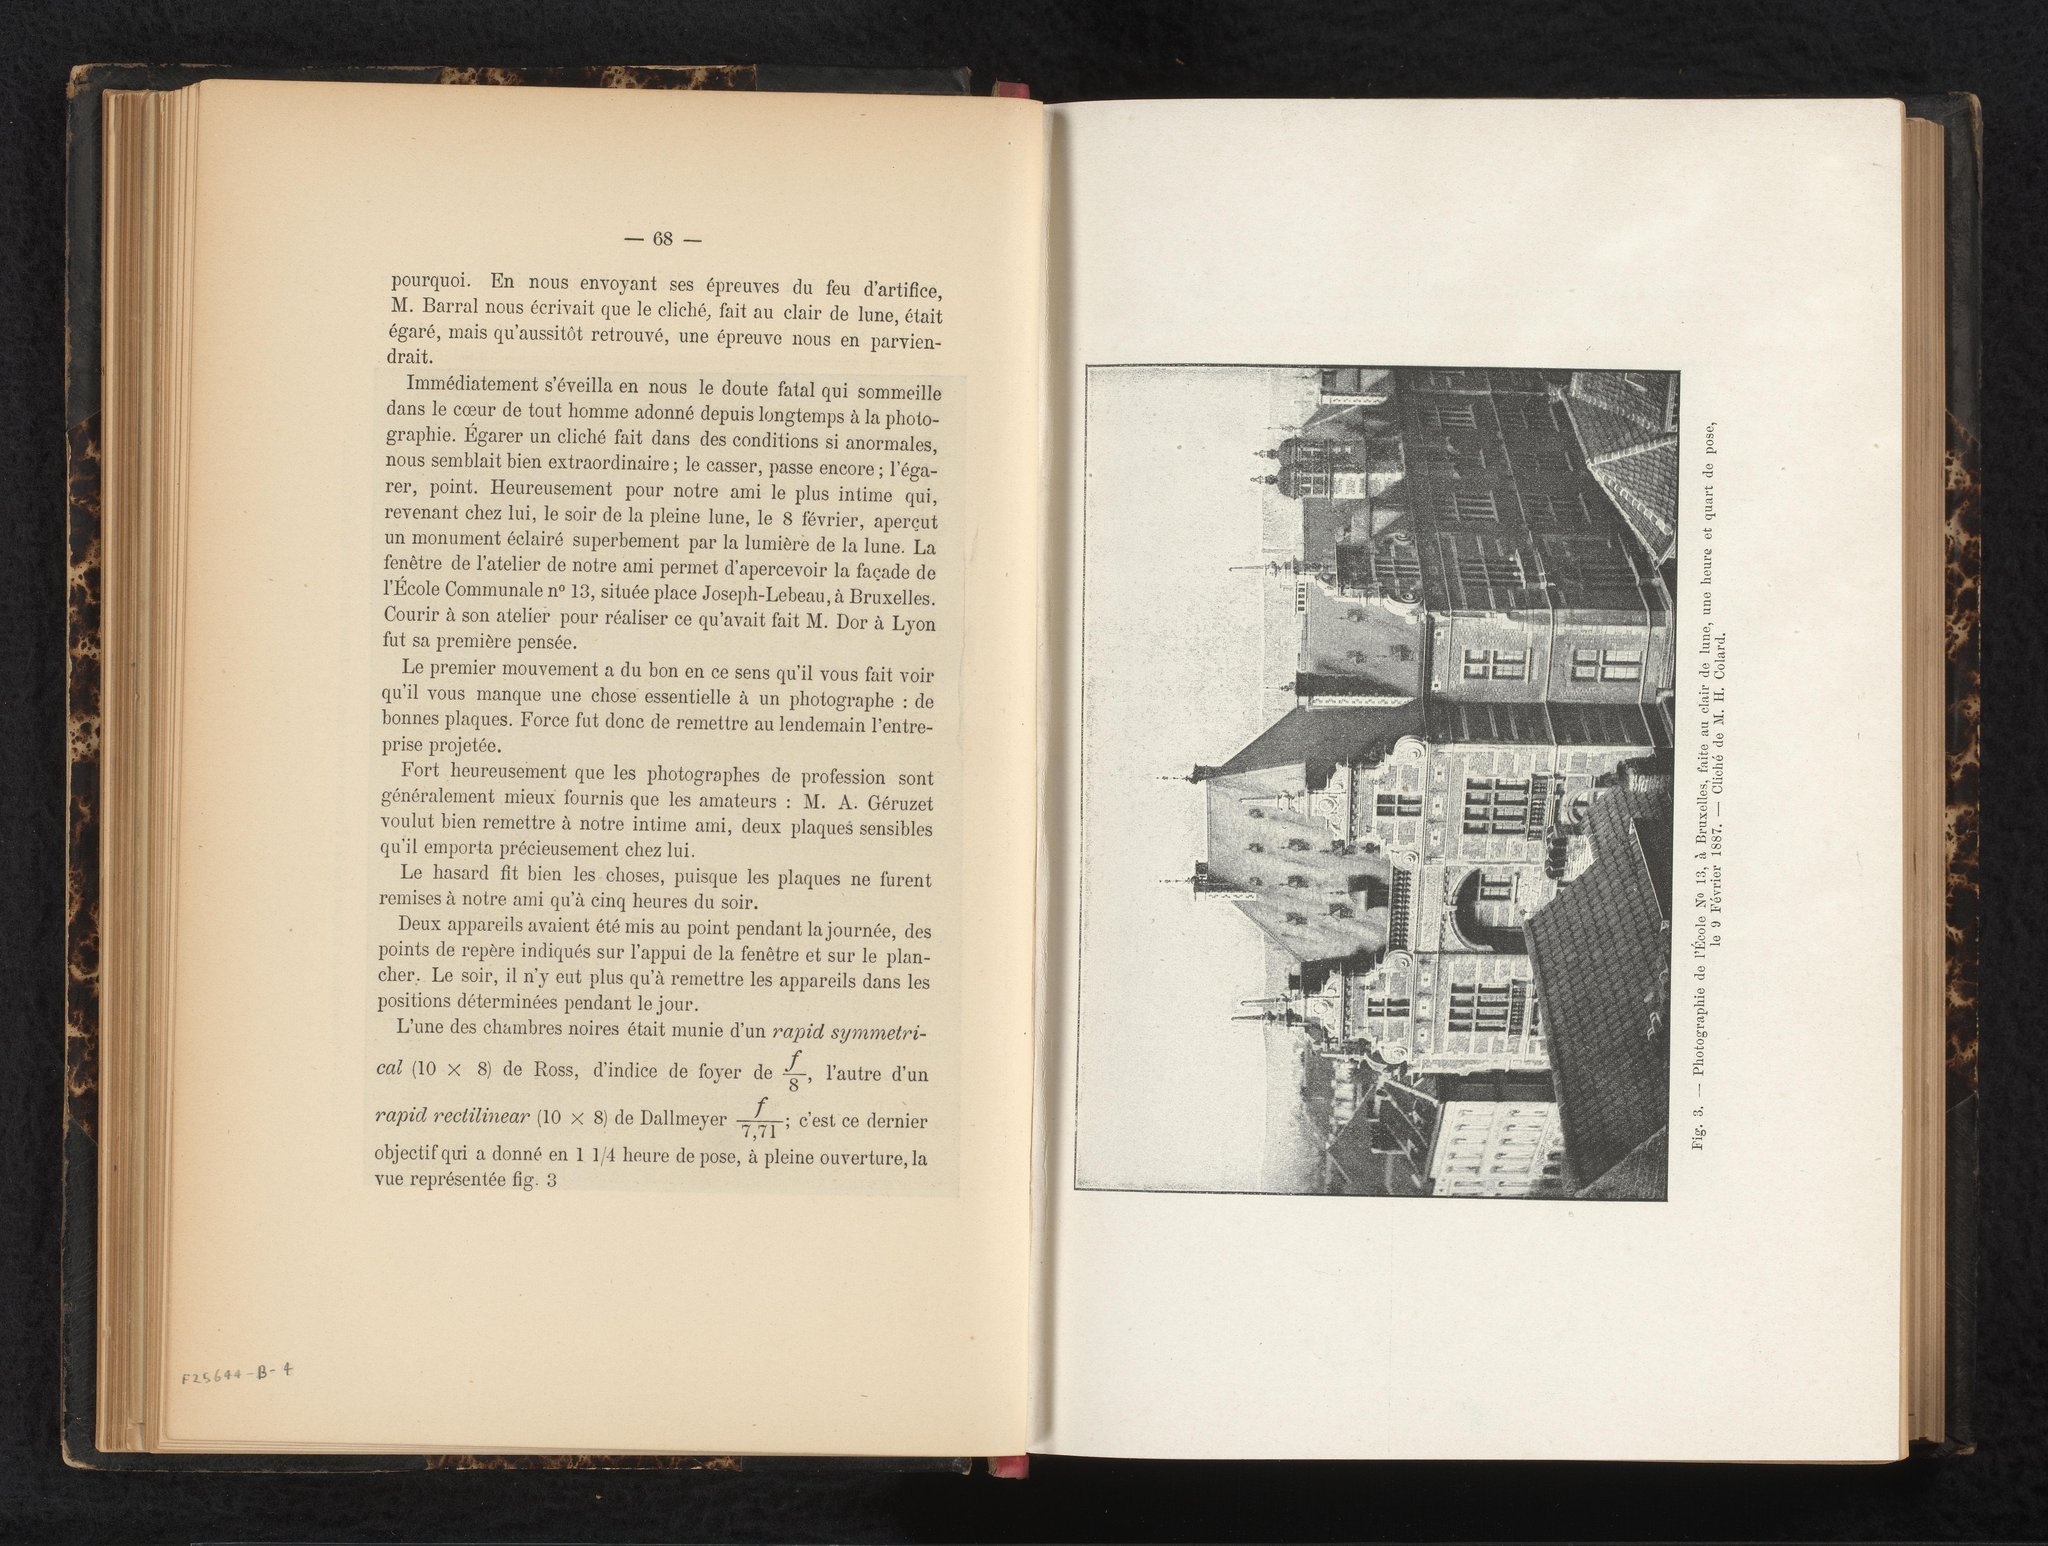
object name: page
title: School aan de Place Joseph-Lebeau te Brussel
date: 1887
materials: paper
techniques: photomechanical printing process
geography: brussels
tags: elementary school; class, form, brussels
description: Prent op ongenummerde pagina tegenover pagina 68.